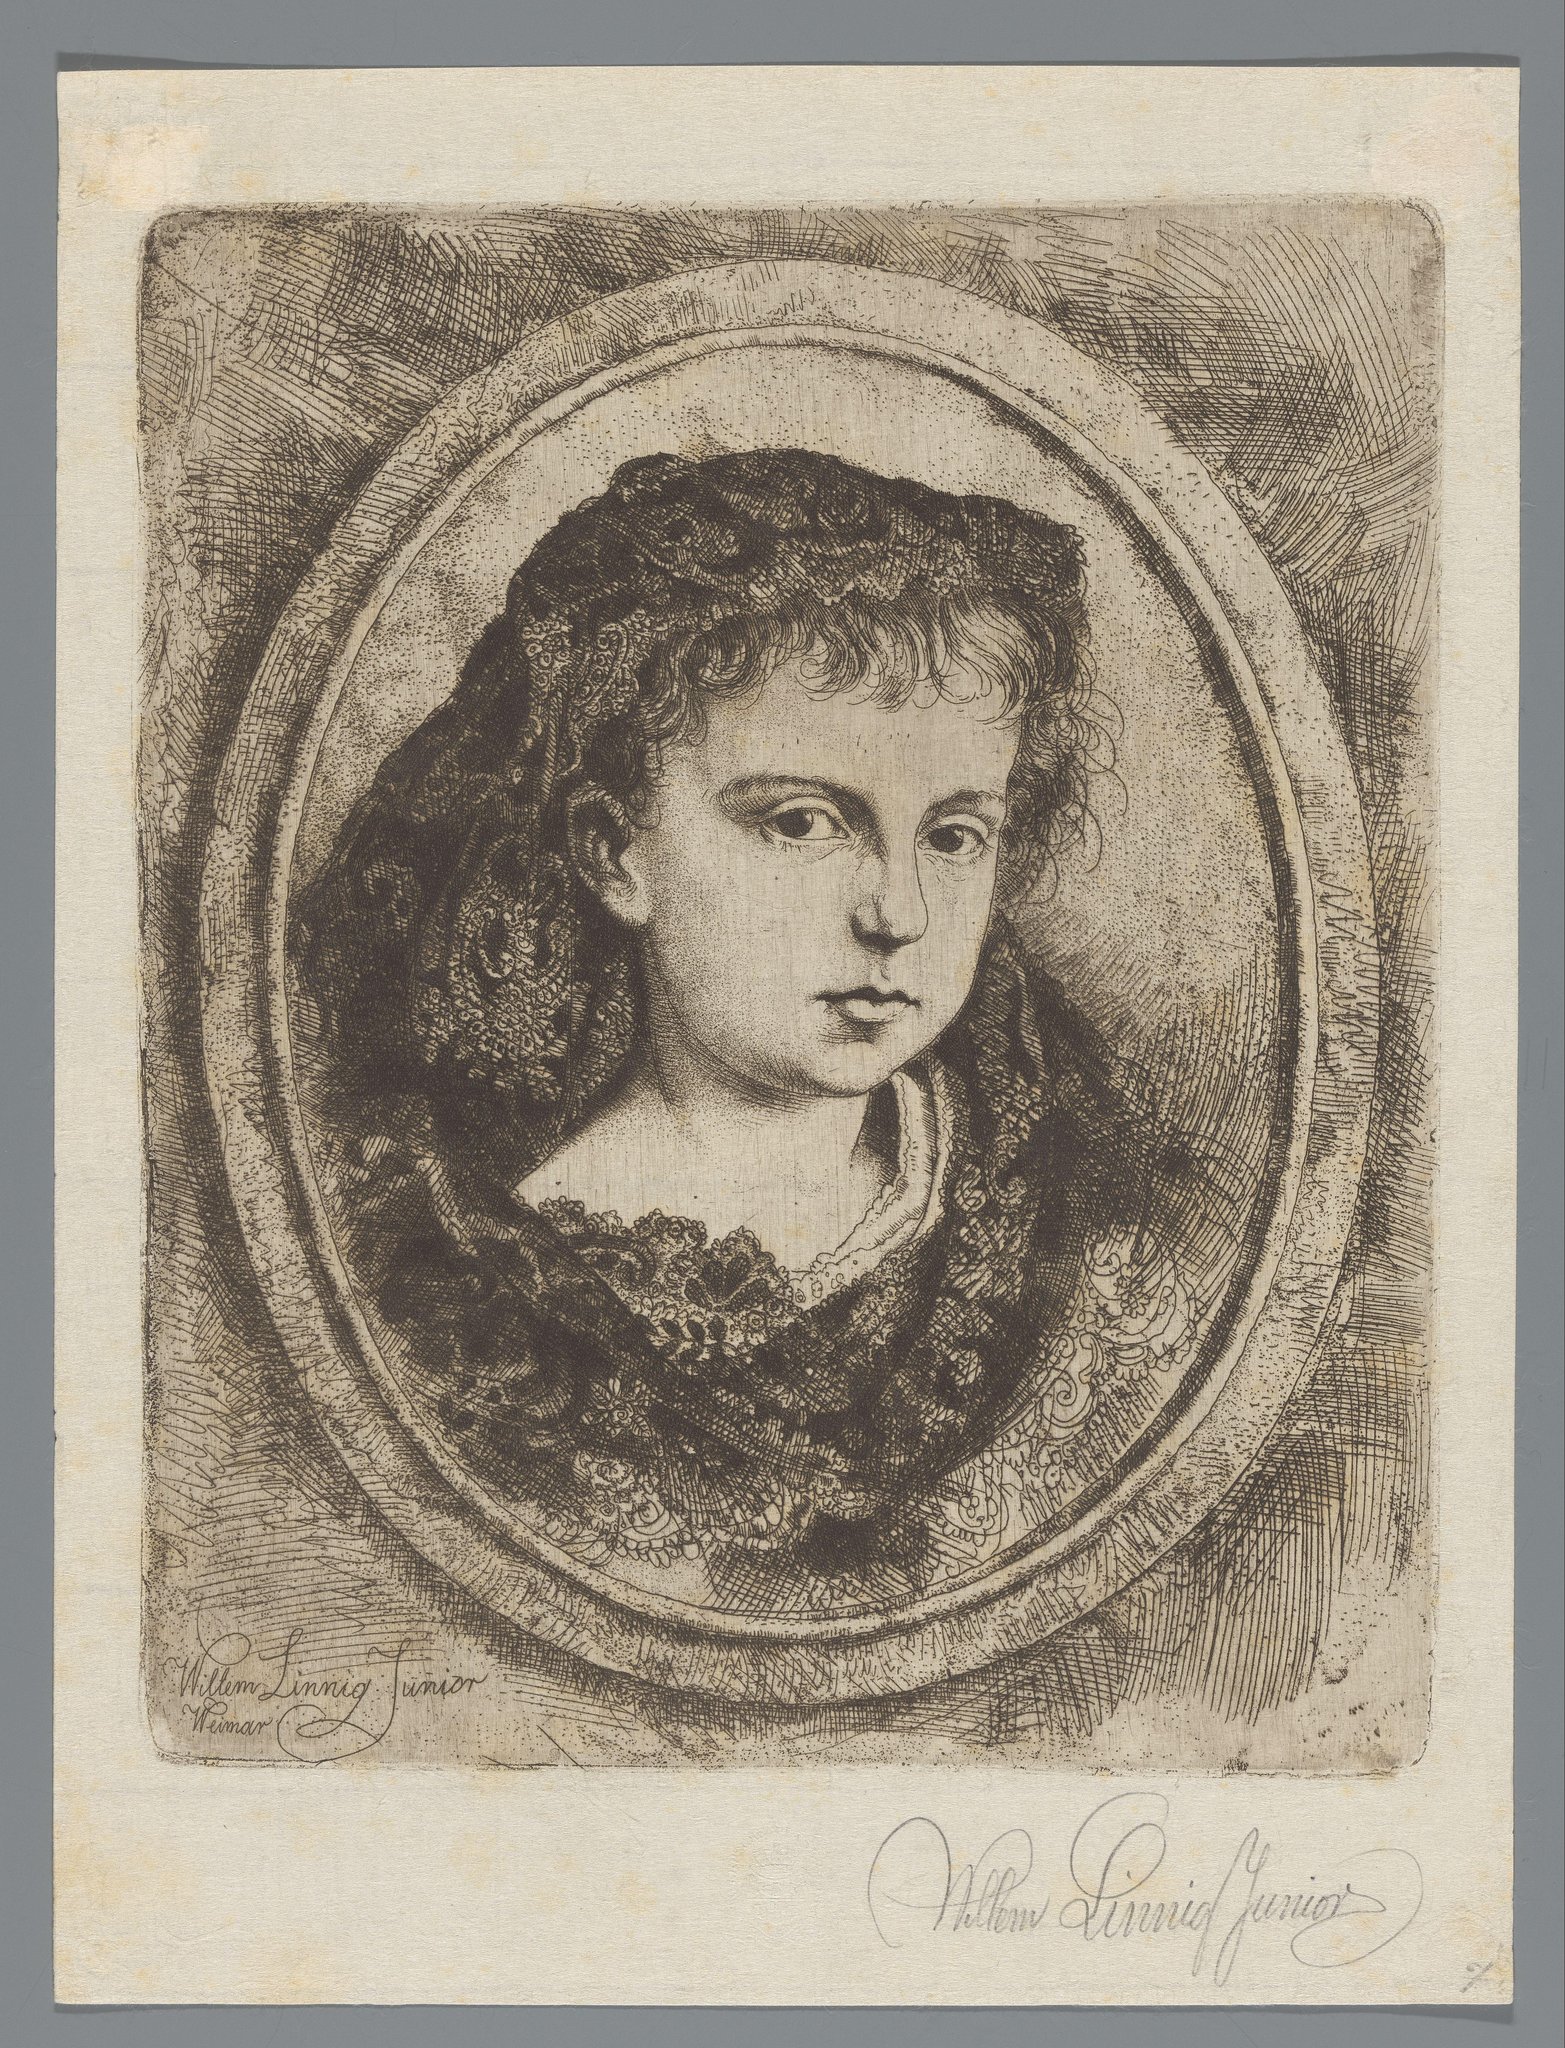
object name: print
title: Portret van een onbekend meisje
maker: willem linnig (ii)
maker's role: print maker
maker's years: 1842-1890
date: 1880-1890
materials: paper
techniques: drypoint, etching, intaglio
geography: weimar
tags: anonymous historical person portrayed alone - bb - woman, girl (child between toddler and youth)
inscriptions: collector's mark: Lugt 2228, workshop stamp: ‘Antwerpsche Etsers 1880’